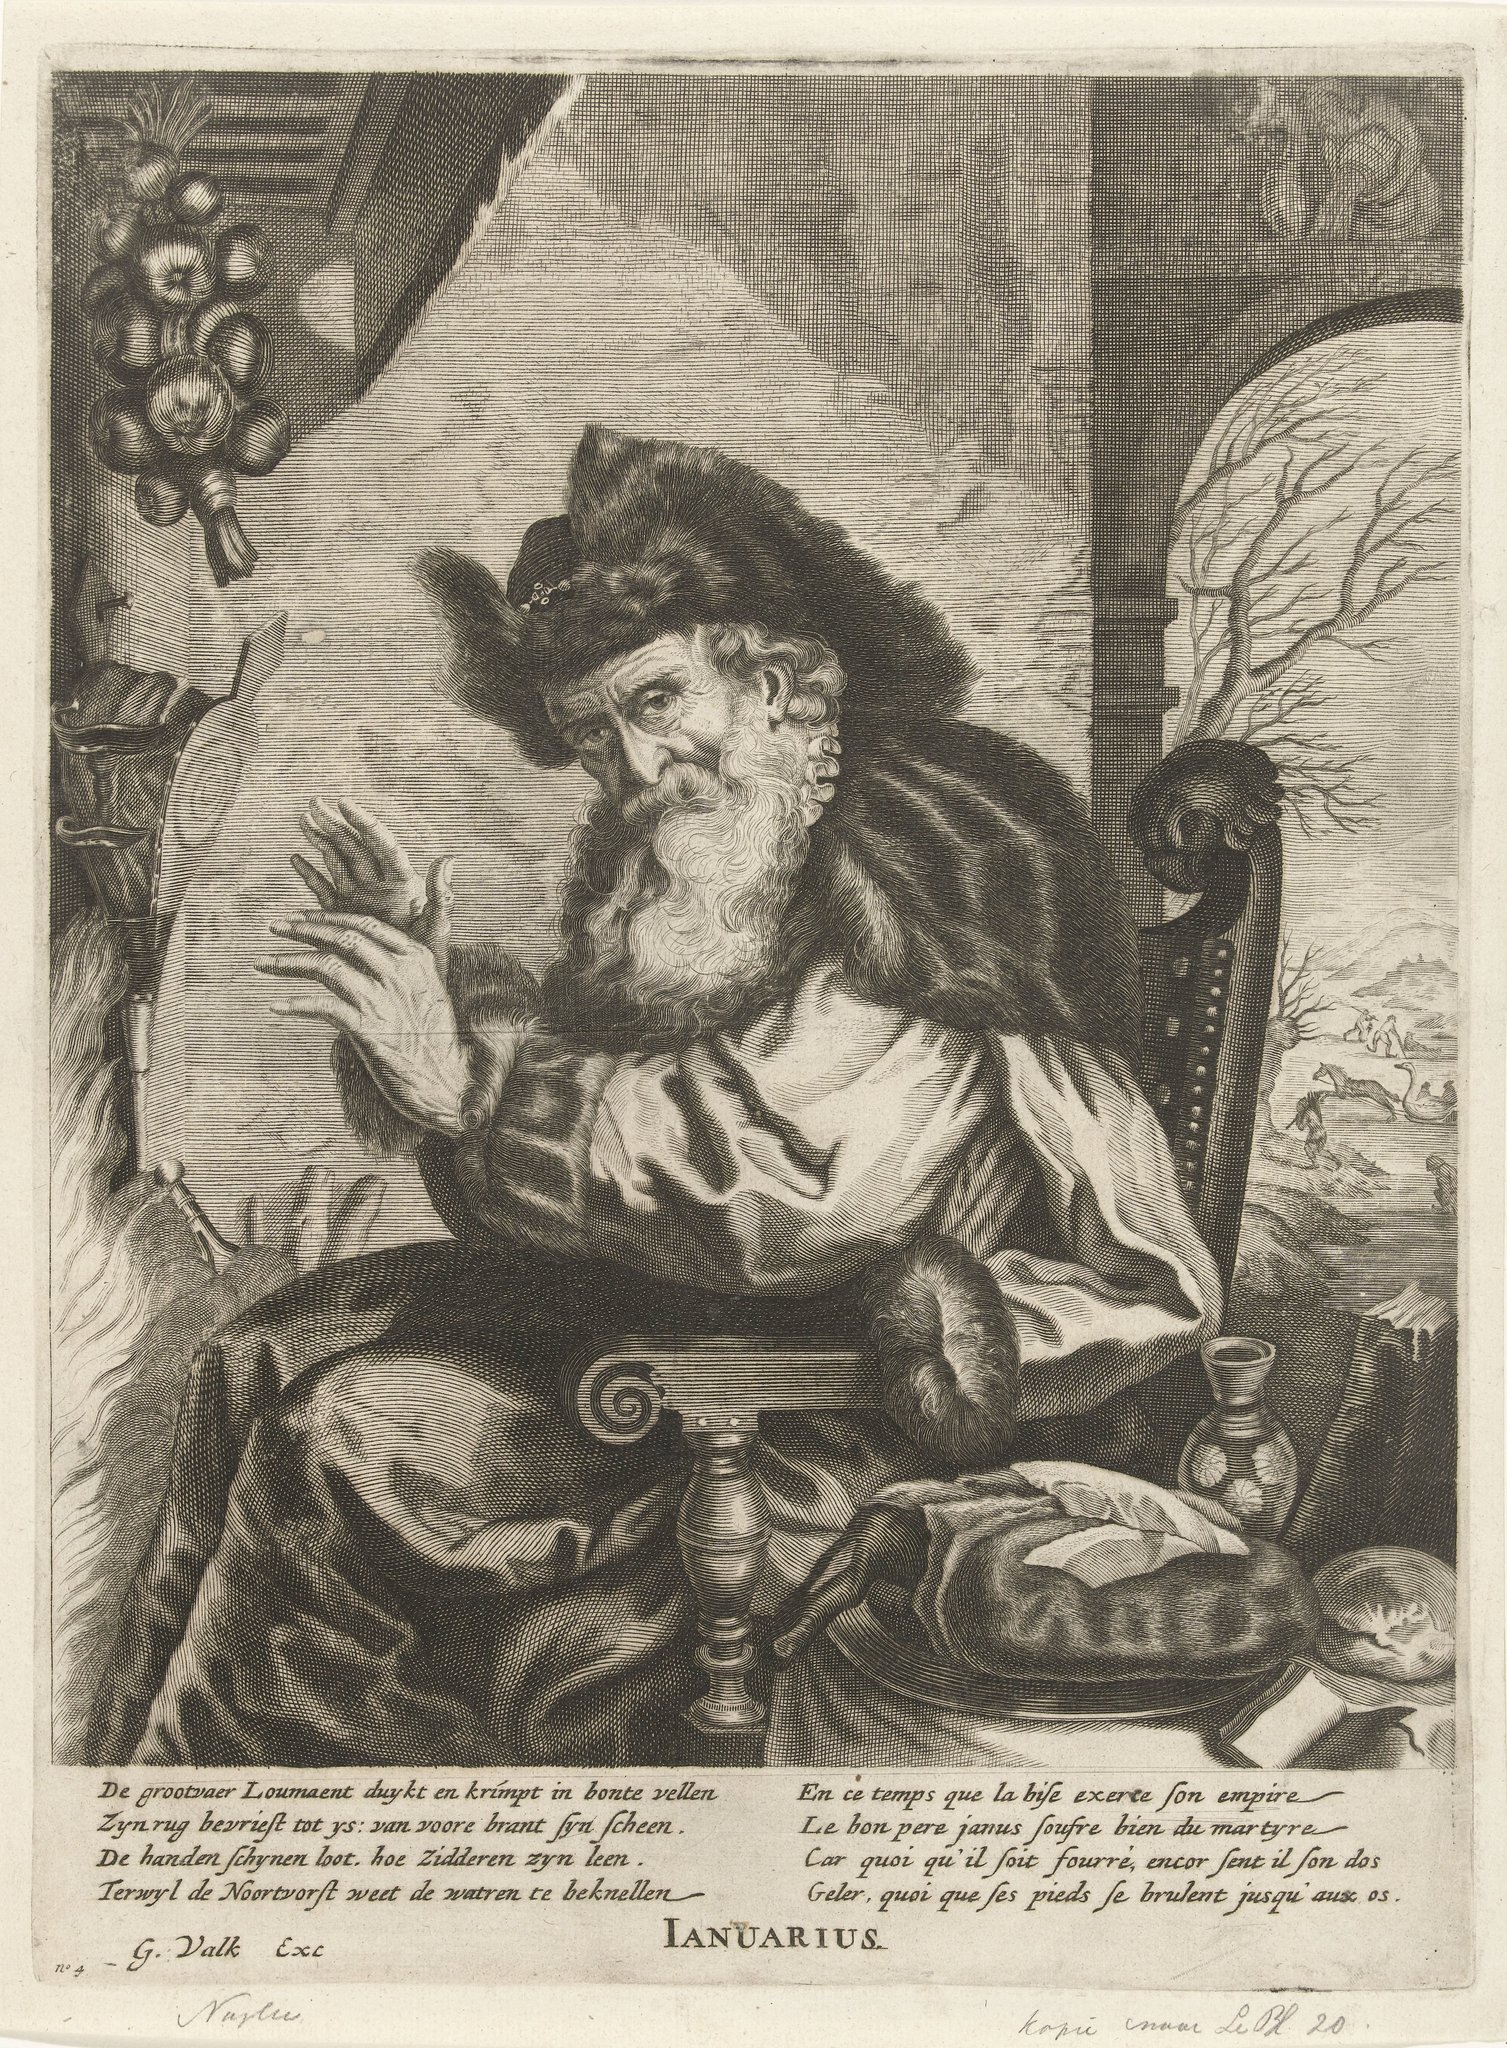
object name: print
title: Ianuarius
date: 1661-1726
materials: paper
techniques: engraving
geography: netherlands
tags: aquarius (zodiacal sign of january), landscape symbolizing january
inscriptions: collector's mark: Lugt 2228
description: Een man in bontmantel en met bontmuts zit in een hoge stoel en warmt zijn handen aan een vuur. Naast hem staat een tafel waarop boeken, een brood en een ham liggen. Door een open deur op de achtergrond een gezicht op een bevroren rivier met schaatsers en boven de deur een afbeelding van het sterrenbeeld waterman. Onder de voorstelling een vers in het Nederlands en in het Frans, elk van vier regels. Kopie in spiegelbeeld naar prent van Jeremias Falck.